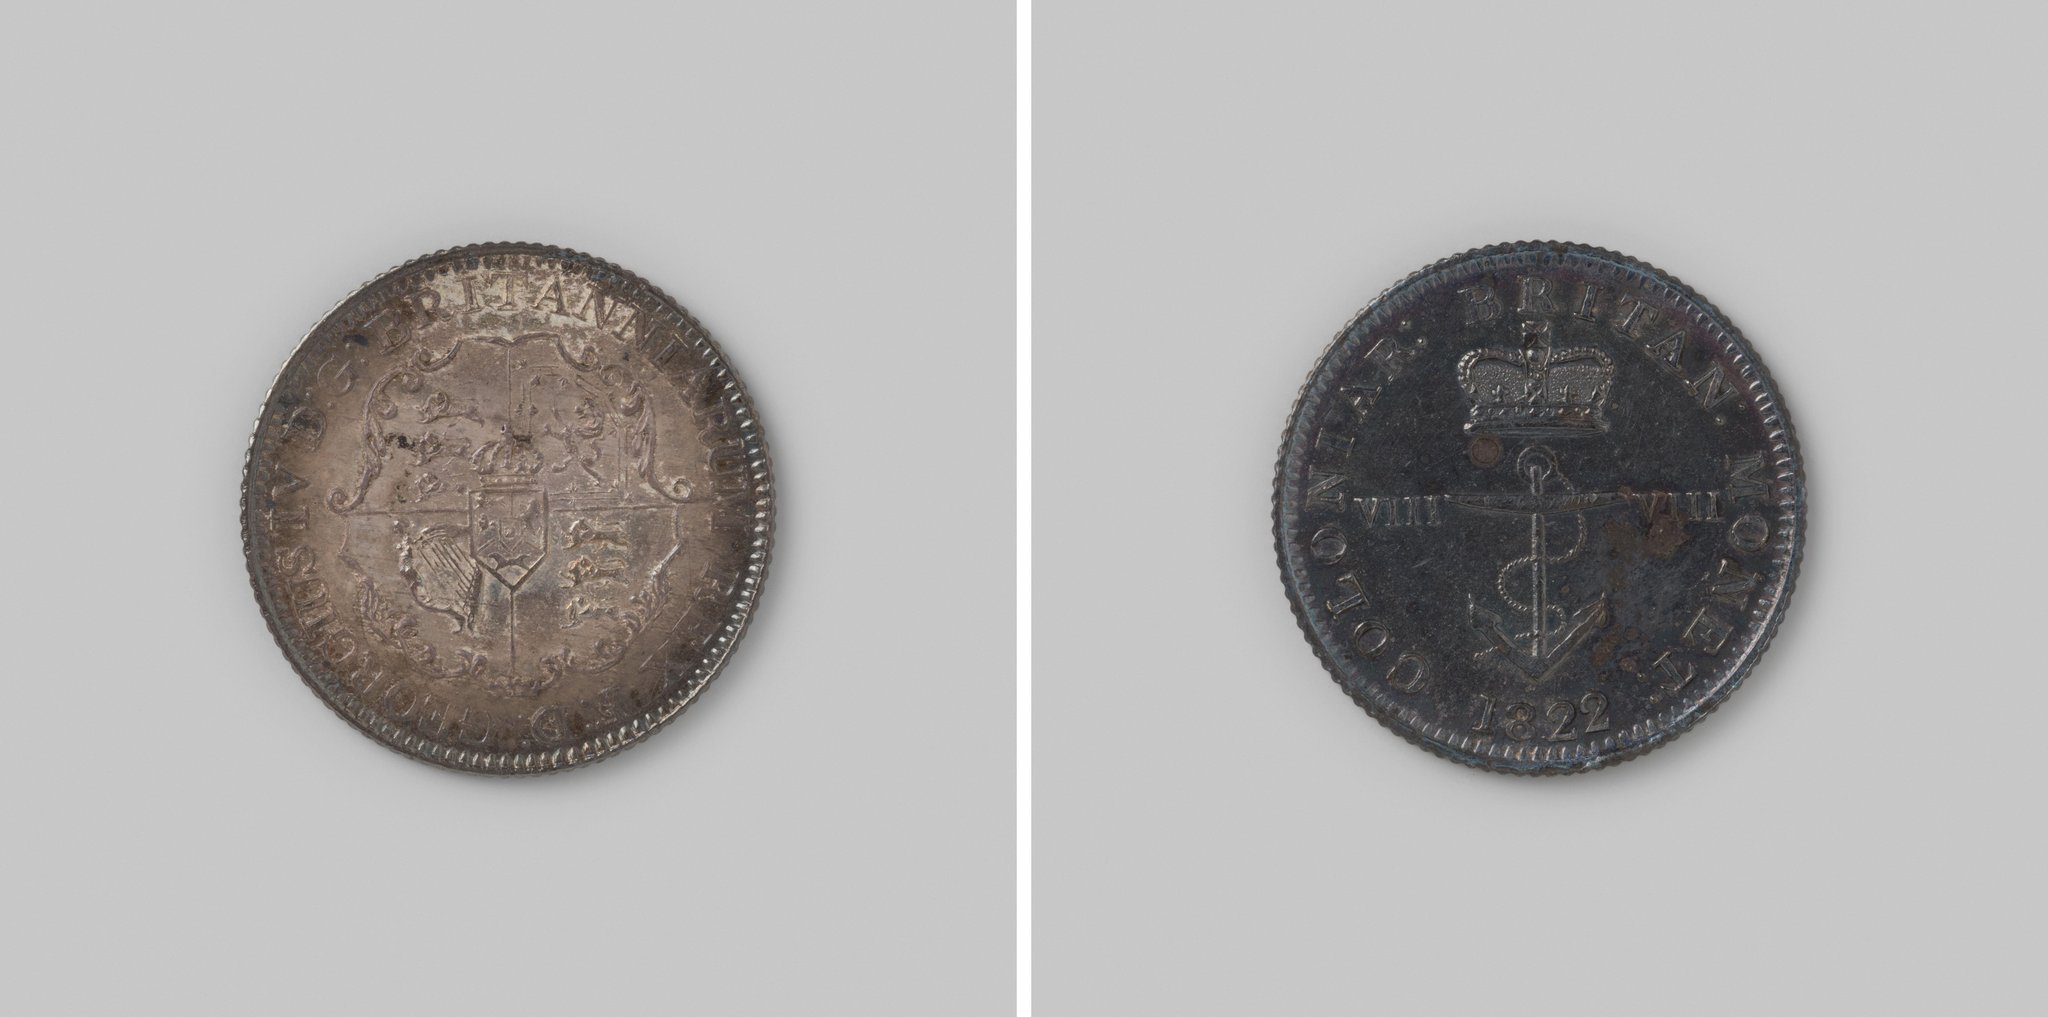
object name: coin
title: 1/8 dollar voor Brits West-Indië van koning George IV, 1822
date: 1822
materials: silver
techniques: striking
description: Zilveren munt. Voorzijde: versierd samengesteld wapenschild. Keerzijde: tussen waarde-aanduidingen VIII [voor: 1/8 ] en VIII anker met touw, waarboven kroon.Daaronder jaartal. Kartelrand.